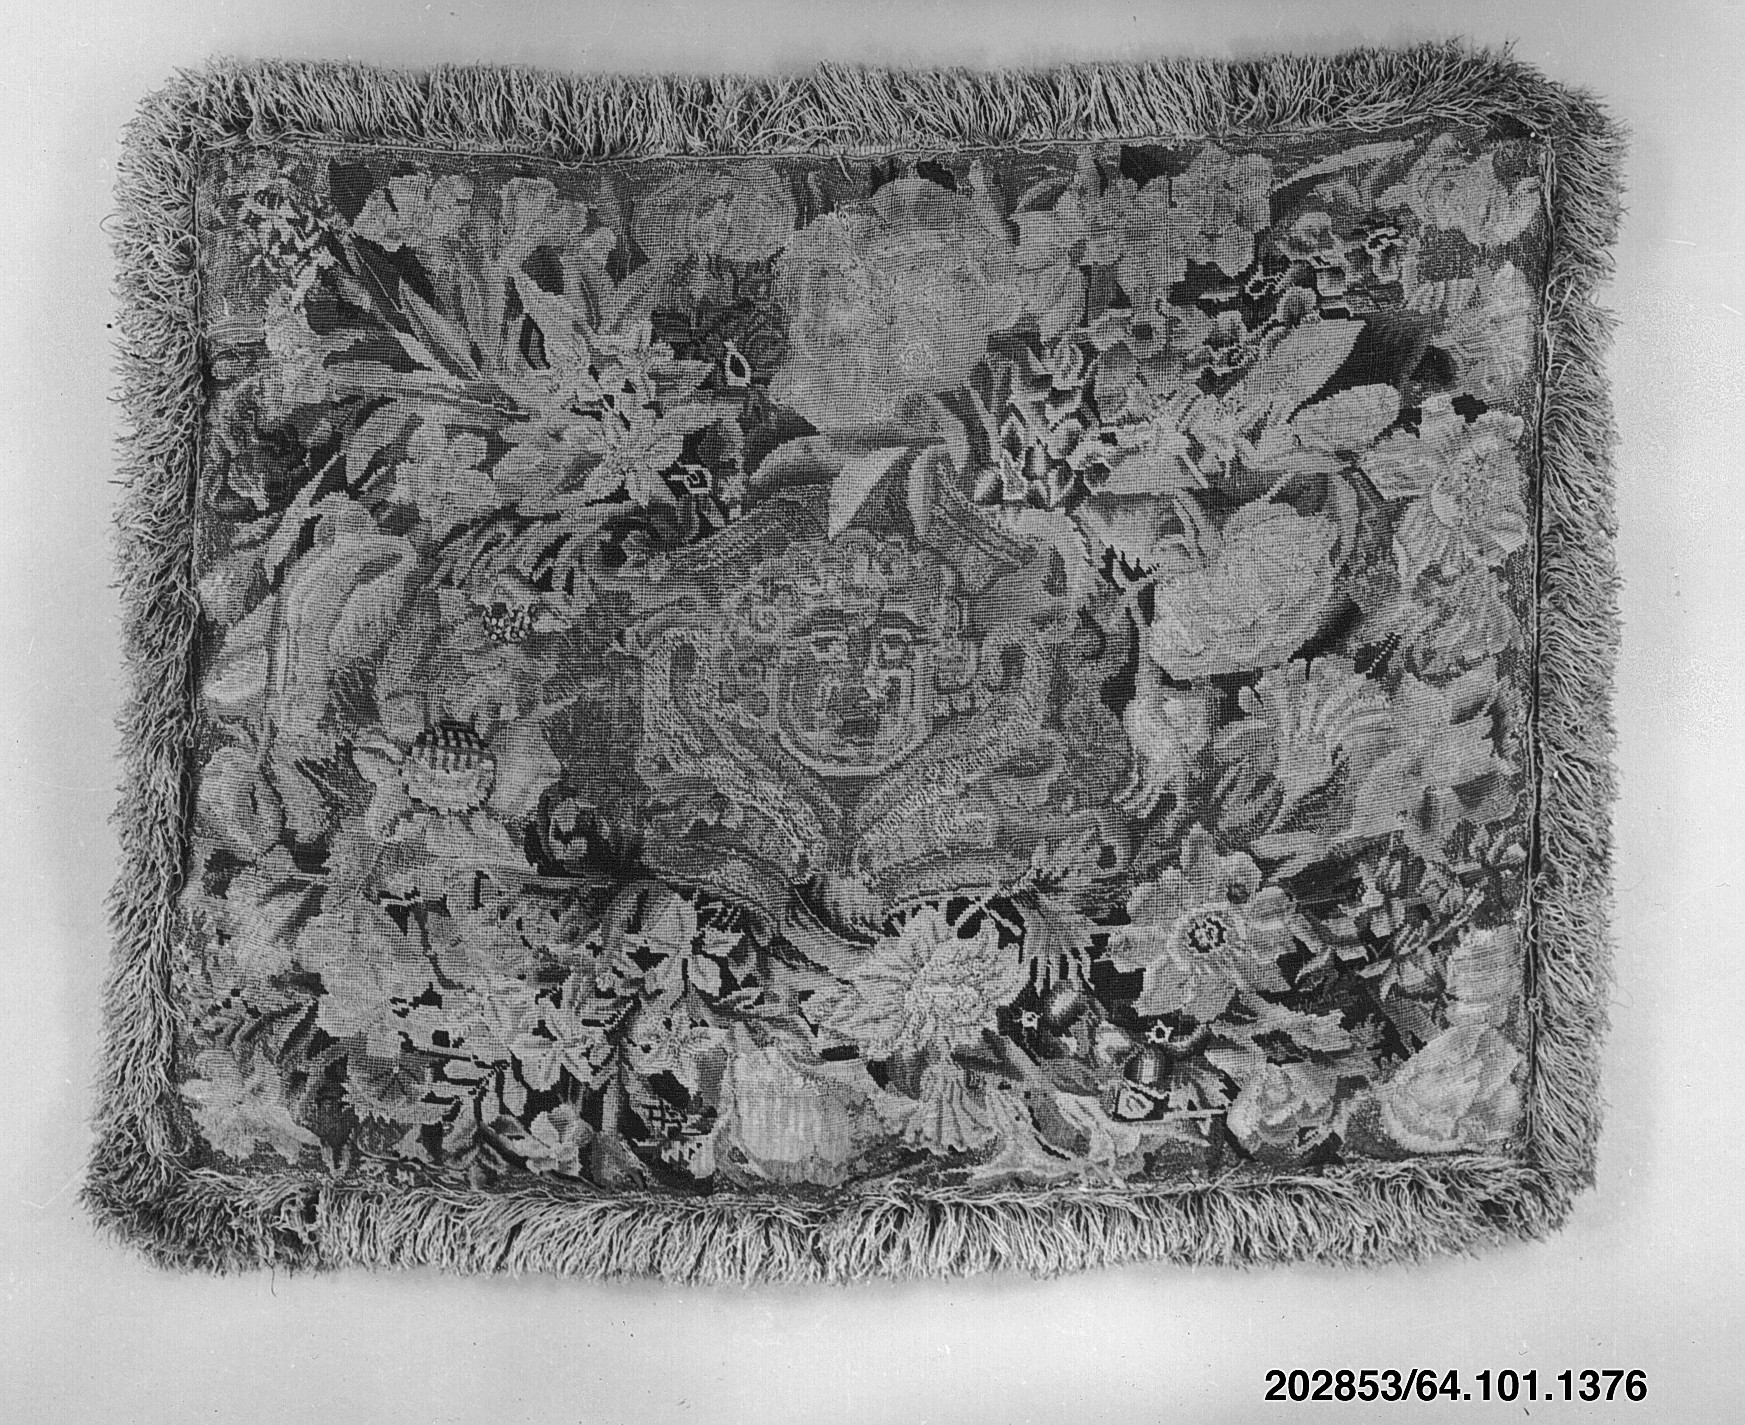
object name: cushion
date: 1601-1625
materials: canvas, metal thread, silk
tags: flowers